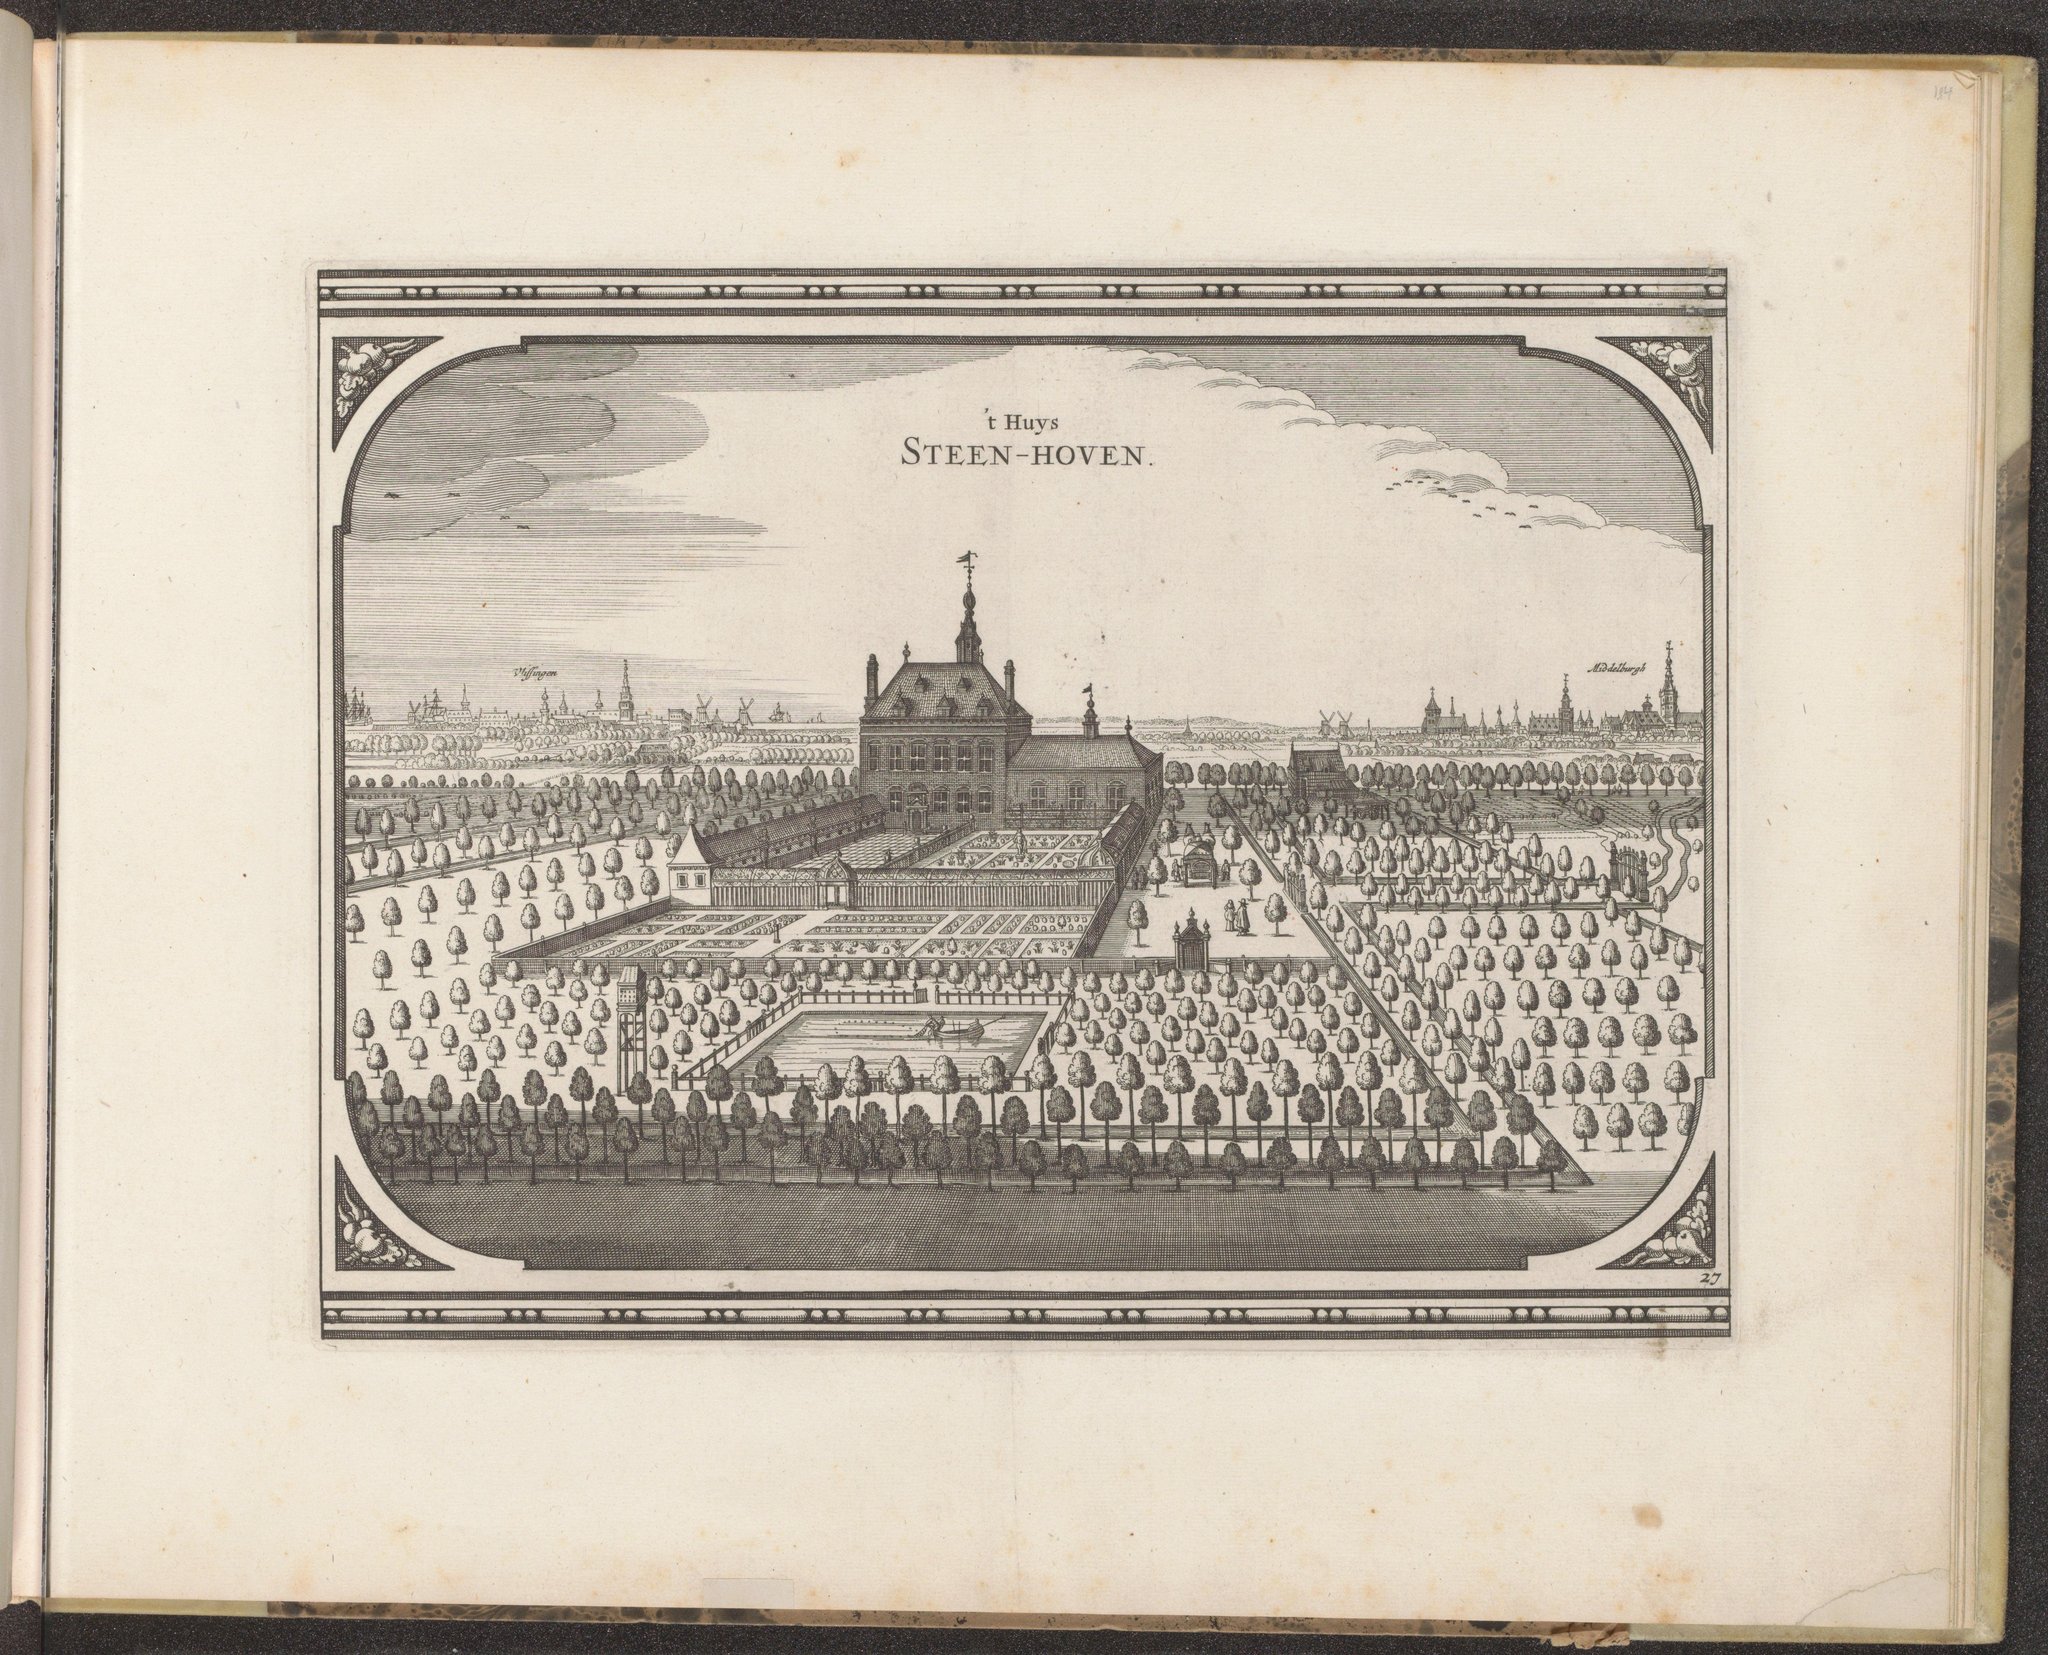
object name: album leaf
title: Speculum Zelandiae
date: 1662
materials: paper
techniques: etching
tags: city-view, and landscape with man-made constructions, country-house, middelburg, flushing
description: Gezicht op Huis Steenhoven, een buitenplaats bij Koudekerke op het eiland Walcheren. Op de achtergrond een zicht op de steden Vlissingen en Middelburg. De prent maakt deel uit van een album.